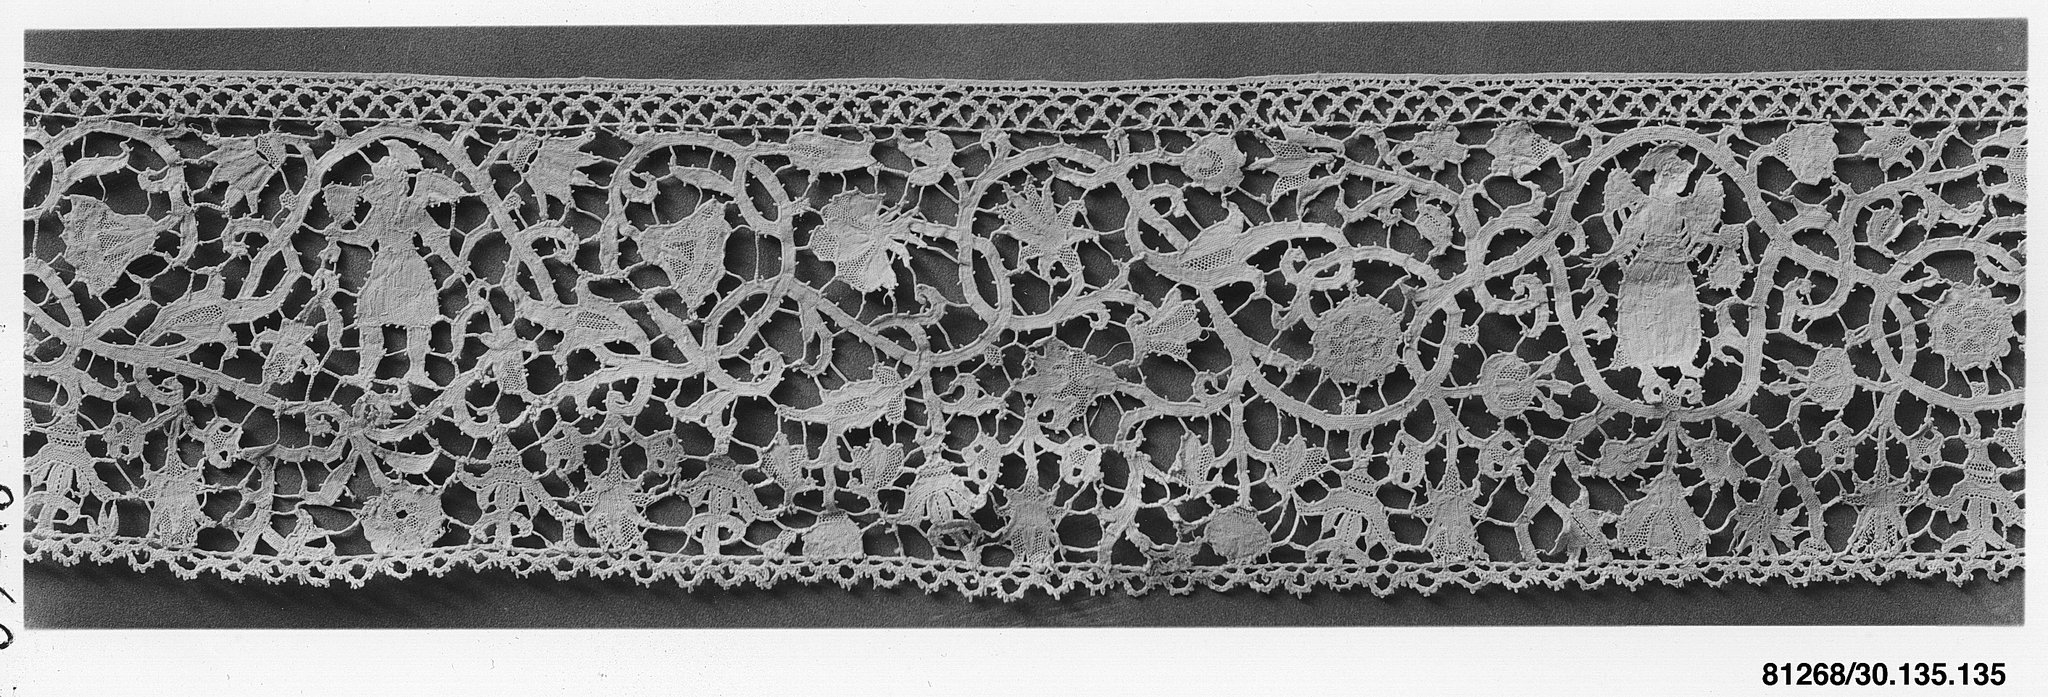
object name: border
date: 1601-1633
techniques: lace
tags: flowers,angels